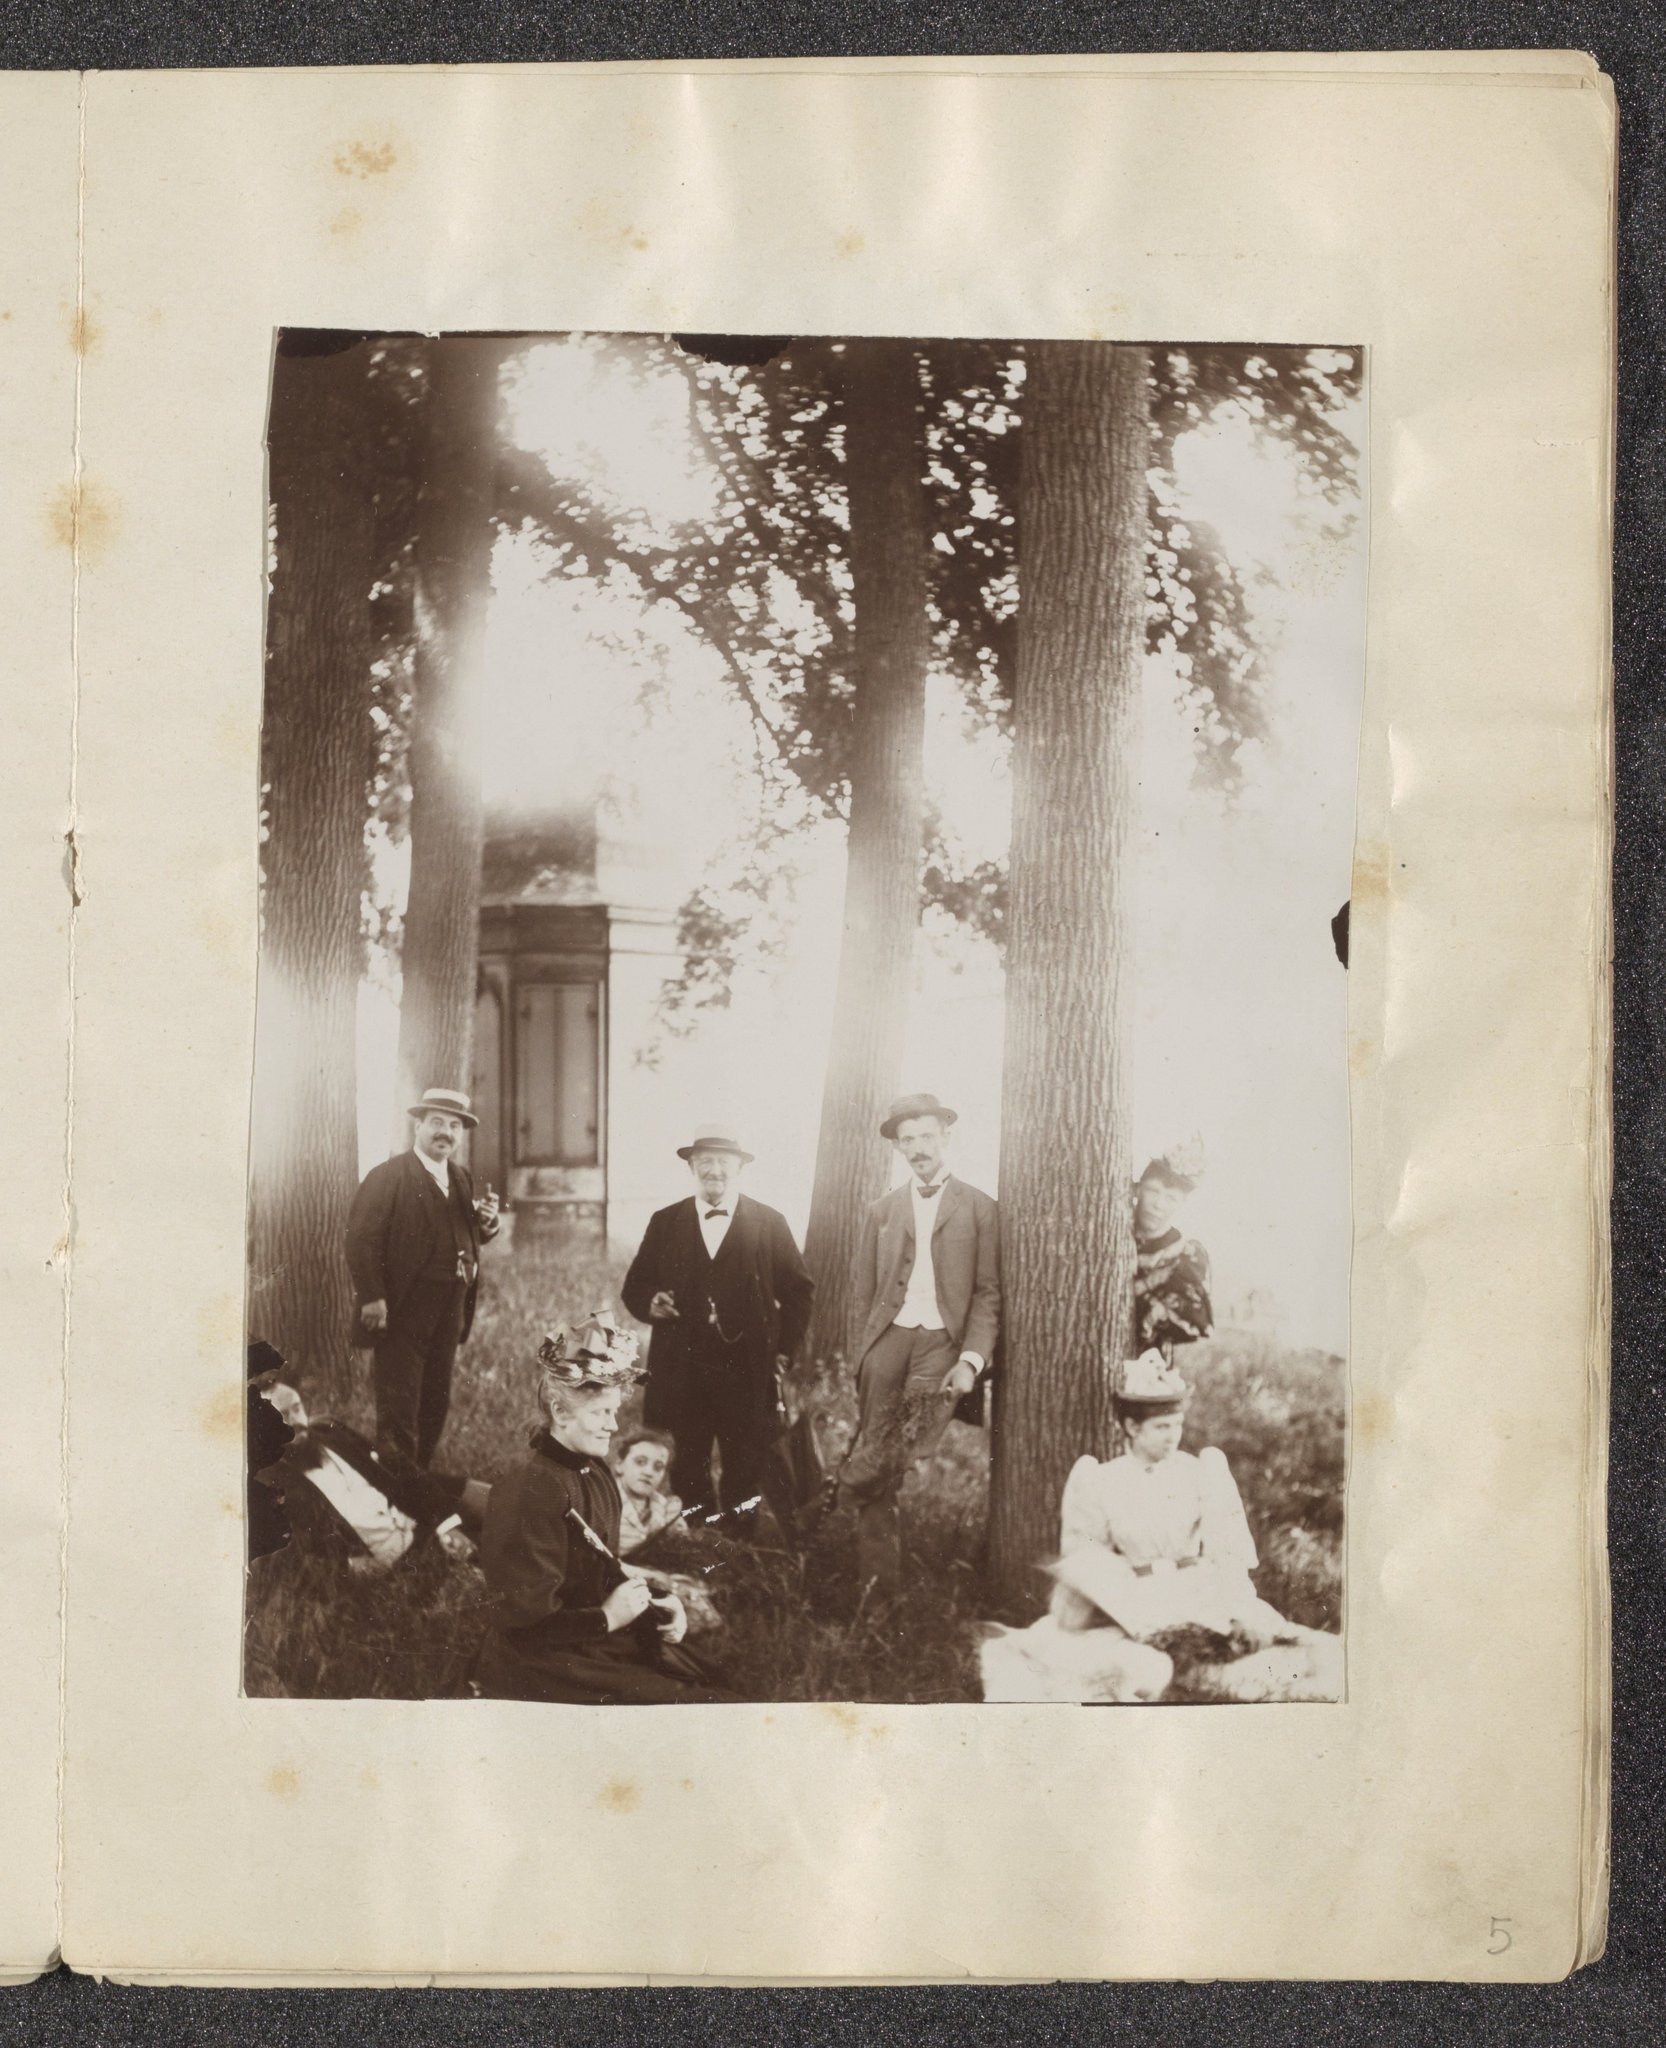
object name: photograph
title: Mannen, vrouwen en een kind poserend bij bomen voor een huis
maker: Anonymous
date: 1900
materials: paper, photographic support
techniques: collodion silver print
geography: france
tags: trees, adult woman, trousers, breeches, adult man, child, historical persons, trees (+ stem, trunk), clothing for the upper part of the body, head-gear: hat, family, relationship, descent, dress, gown, three generations (family group), france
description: Onderdeel van Album met 8 foto's van (vermoedelijk) een Franse familie.